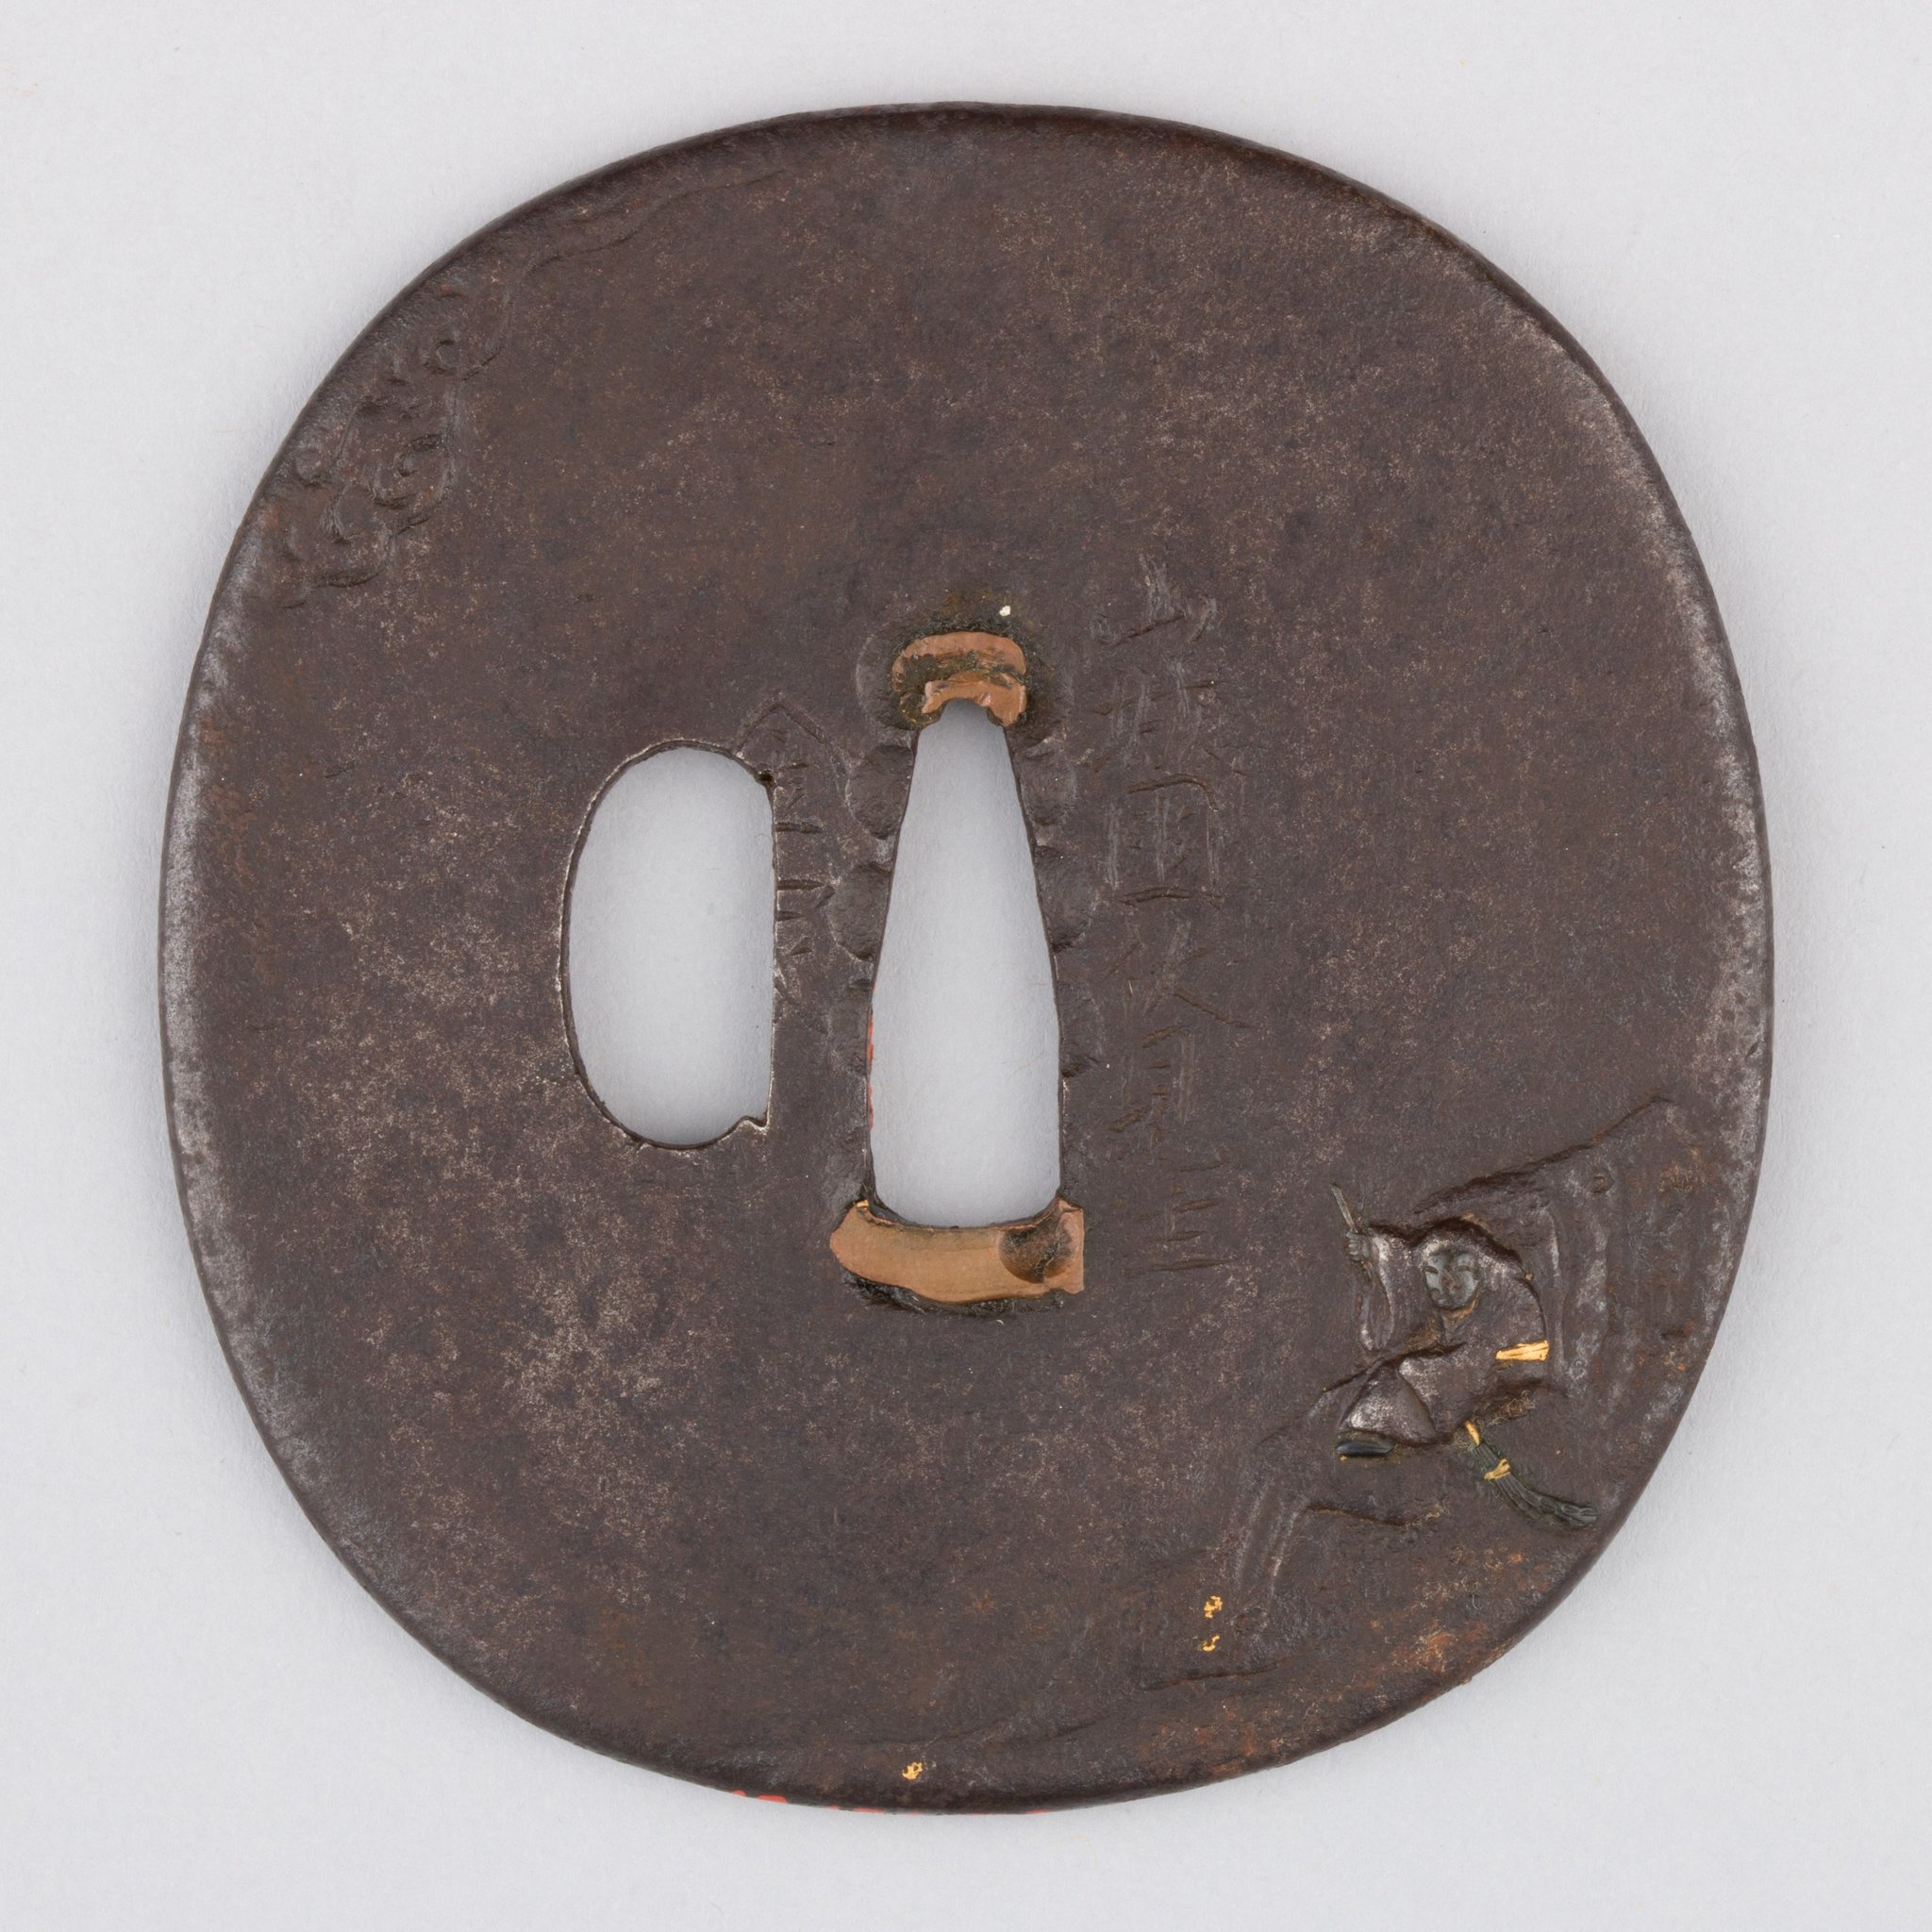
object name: sword guard tsuba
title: Sword Guard (Tsuba)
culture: japanese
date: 1615-1868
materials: copper, iron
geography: japan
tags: men